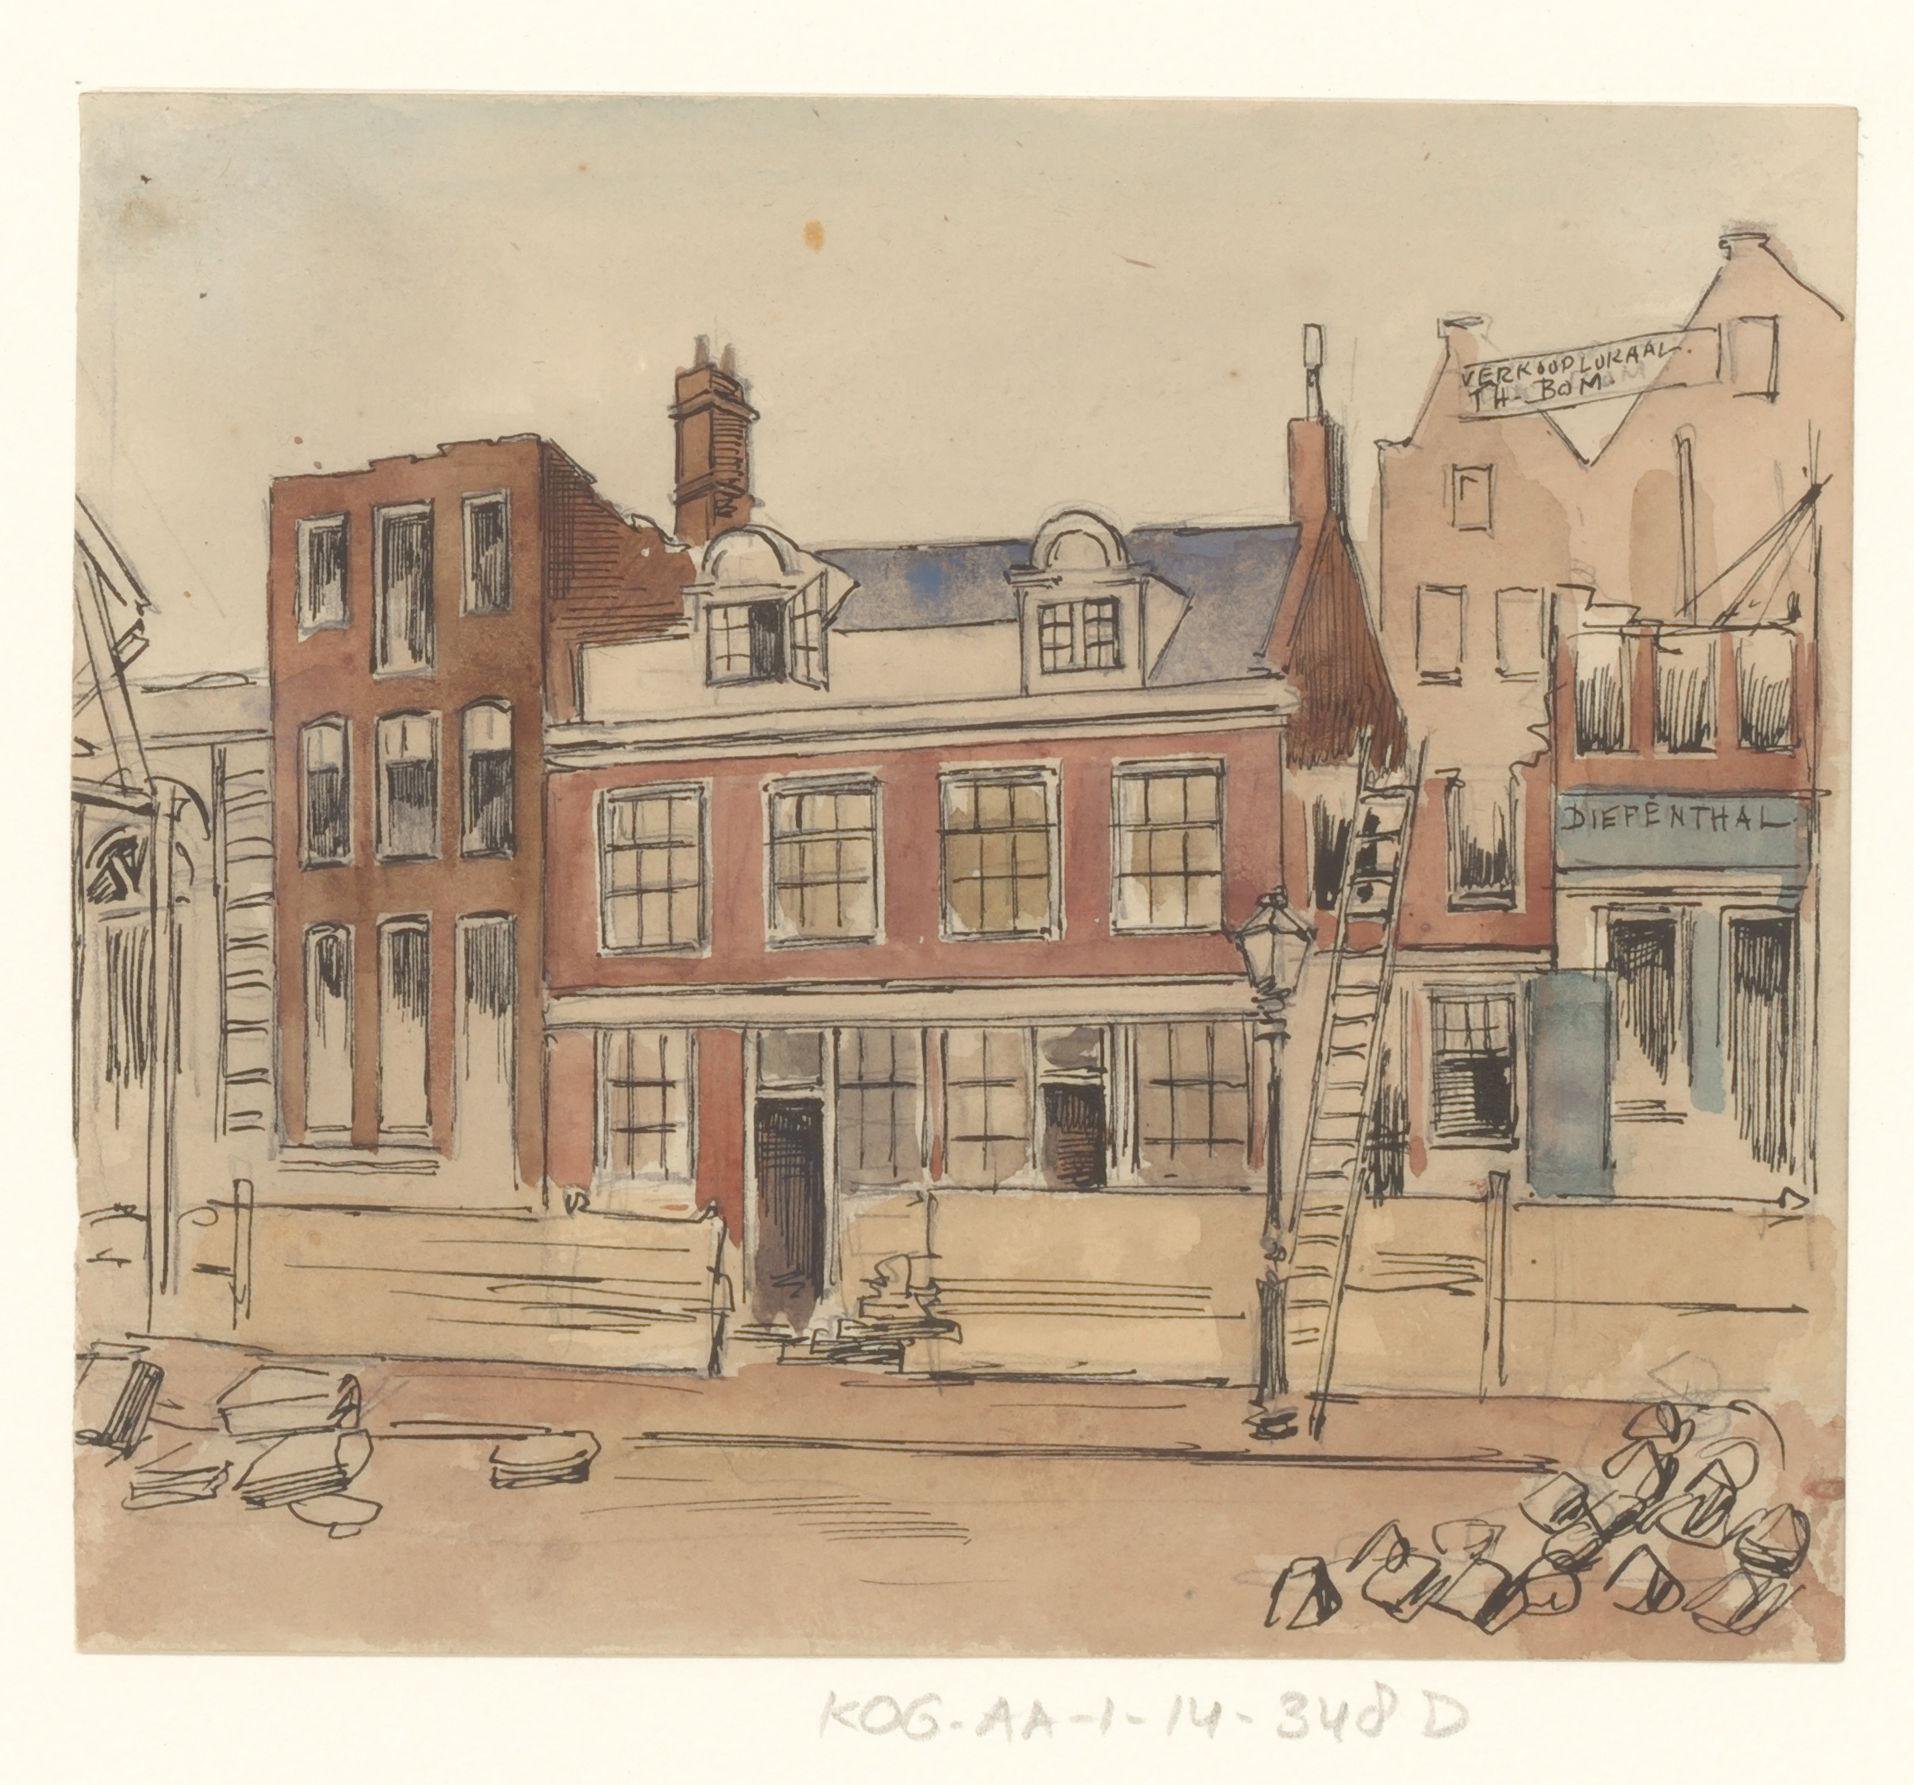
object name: drawing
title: Gezicht op een bouwterrein aan de Nieuwezijds Voorburgwal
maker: willem steelink (ii)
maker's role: draughtsman, print maker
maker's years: 1856-1928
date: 1866-1928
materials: ink, paper, pencil, watercolor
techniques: brush, pen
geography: amsterdam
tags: city-view in general; 'veduta', building-site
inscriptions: collector's mark: ‘14’ Lugt 1641b, inscription: ‘Port. 14 - 348d’, inscription: ‘onder rechts’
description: Onderwerpsrubriek binnen de Atlas Amsterdam: Verhulststraat (Johannes), Viaducten, Vierwindenstraat, Vinkenbuurt, Vinkenpad, Vinkenstraat, Vischsteeg, Vliegendesteeg, Voetboogstraat, Volewijk, Vondelstraat, Voorburgwal (N.Z.).